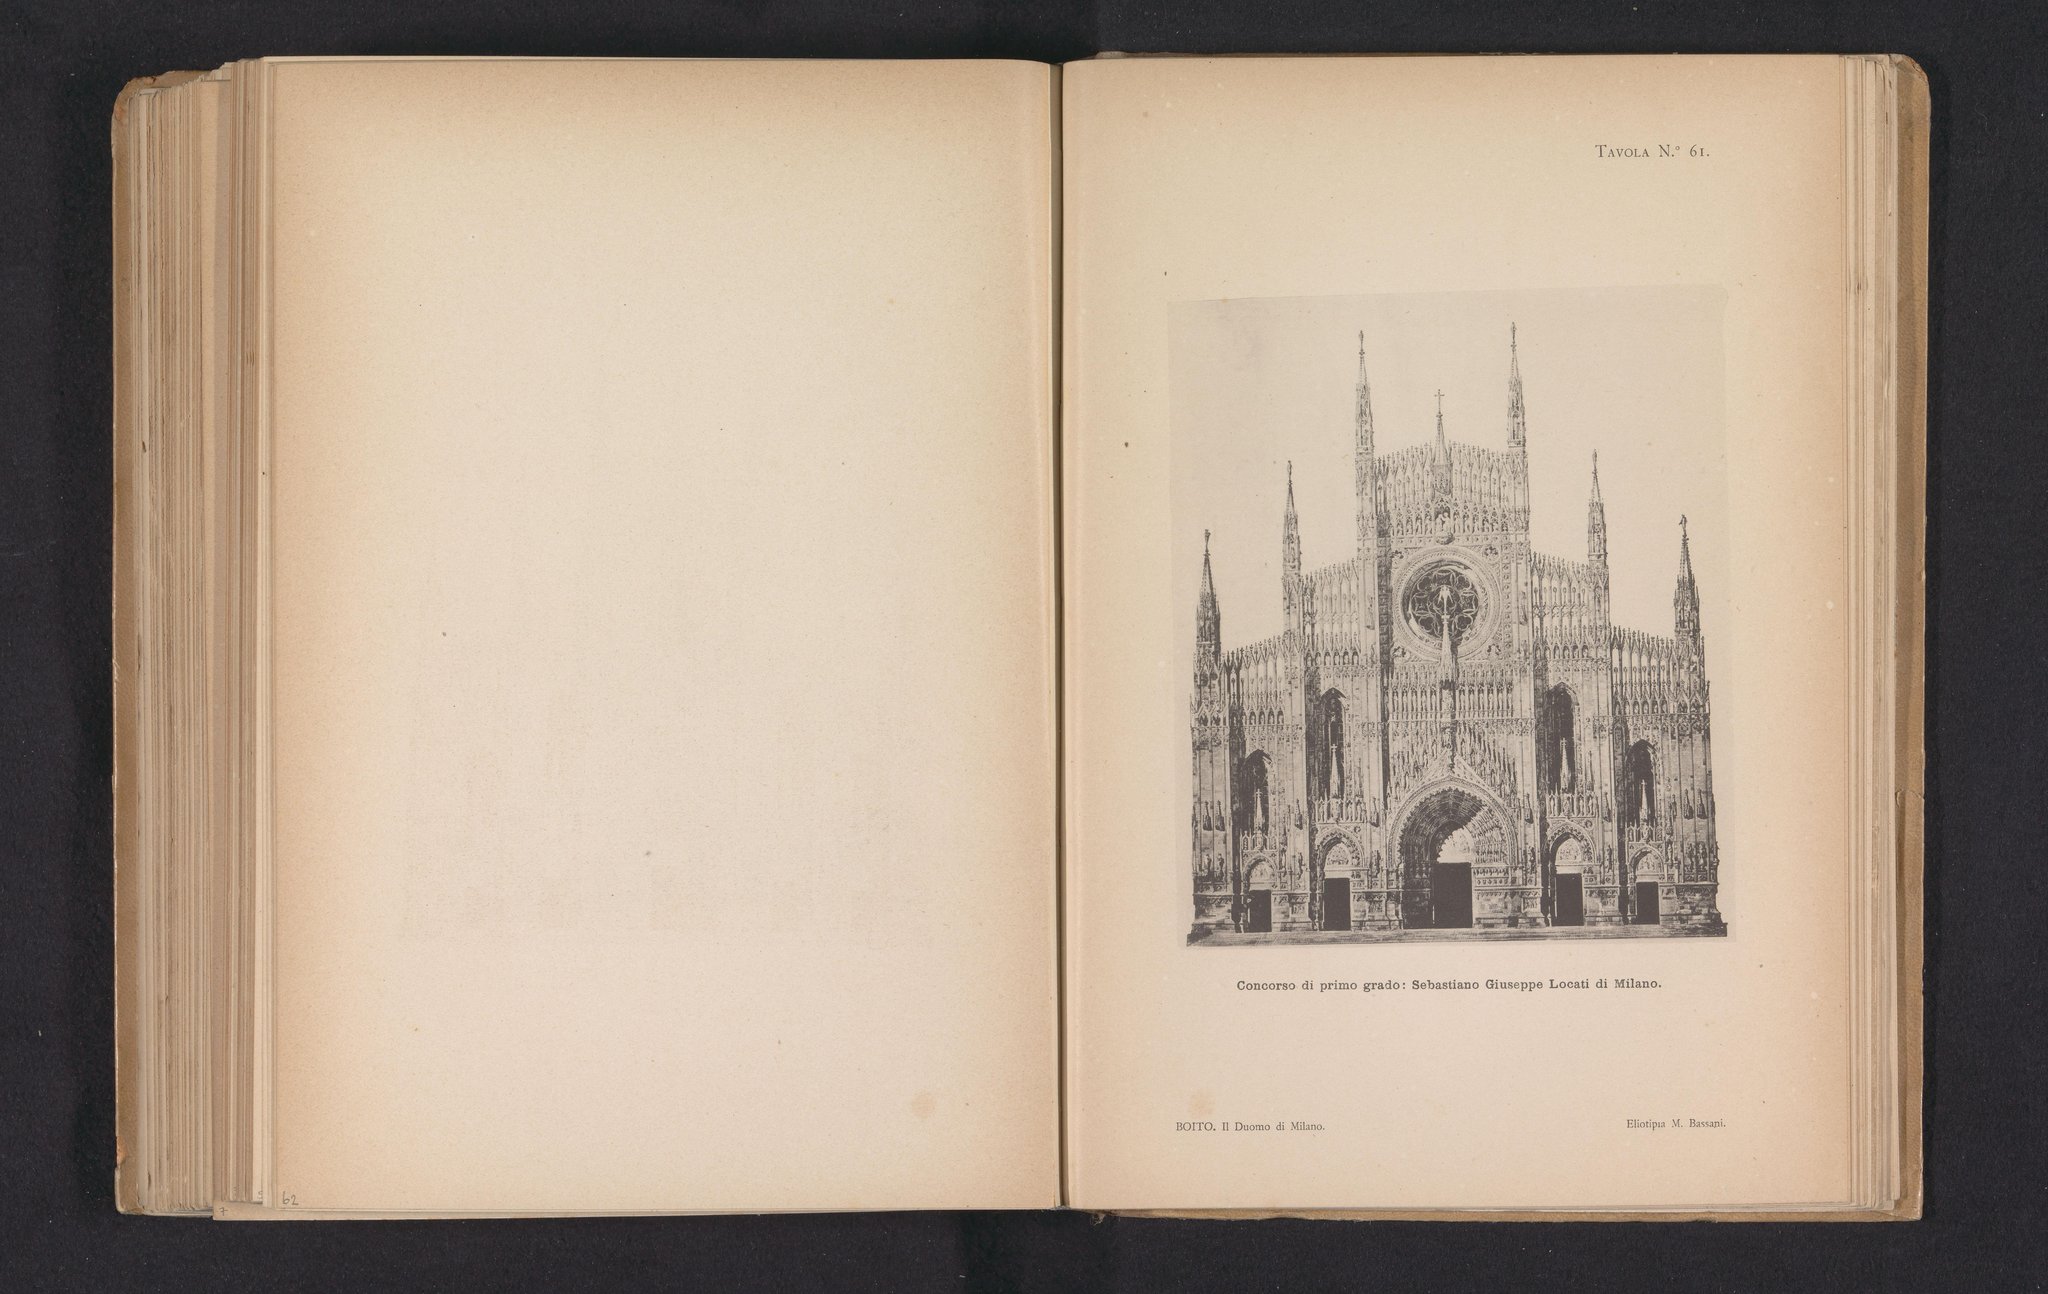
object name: reproduction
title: Concorso di primo grado : Sebastiano Giuseppe Locati di Milano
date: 1886-1889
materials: paper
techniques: photograph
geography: milan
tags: drawing, sketch, parts of church exterior and annexes: façade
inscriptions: number: ‘Tavola No. 61.’